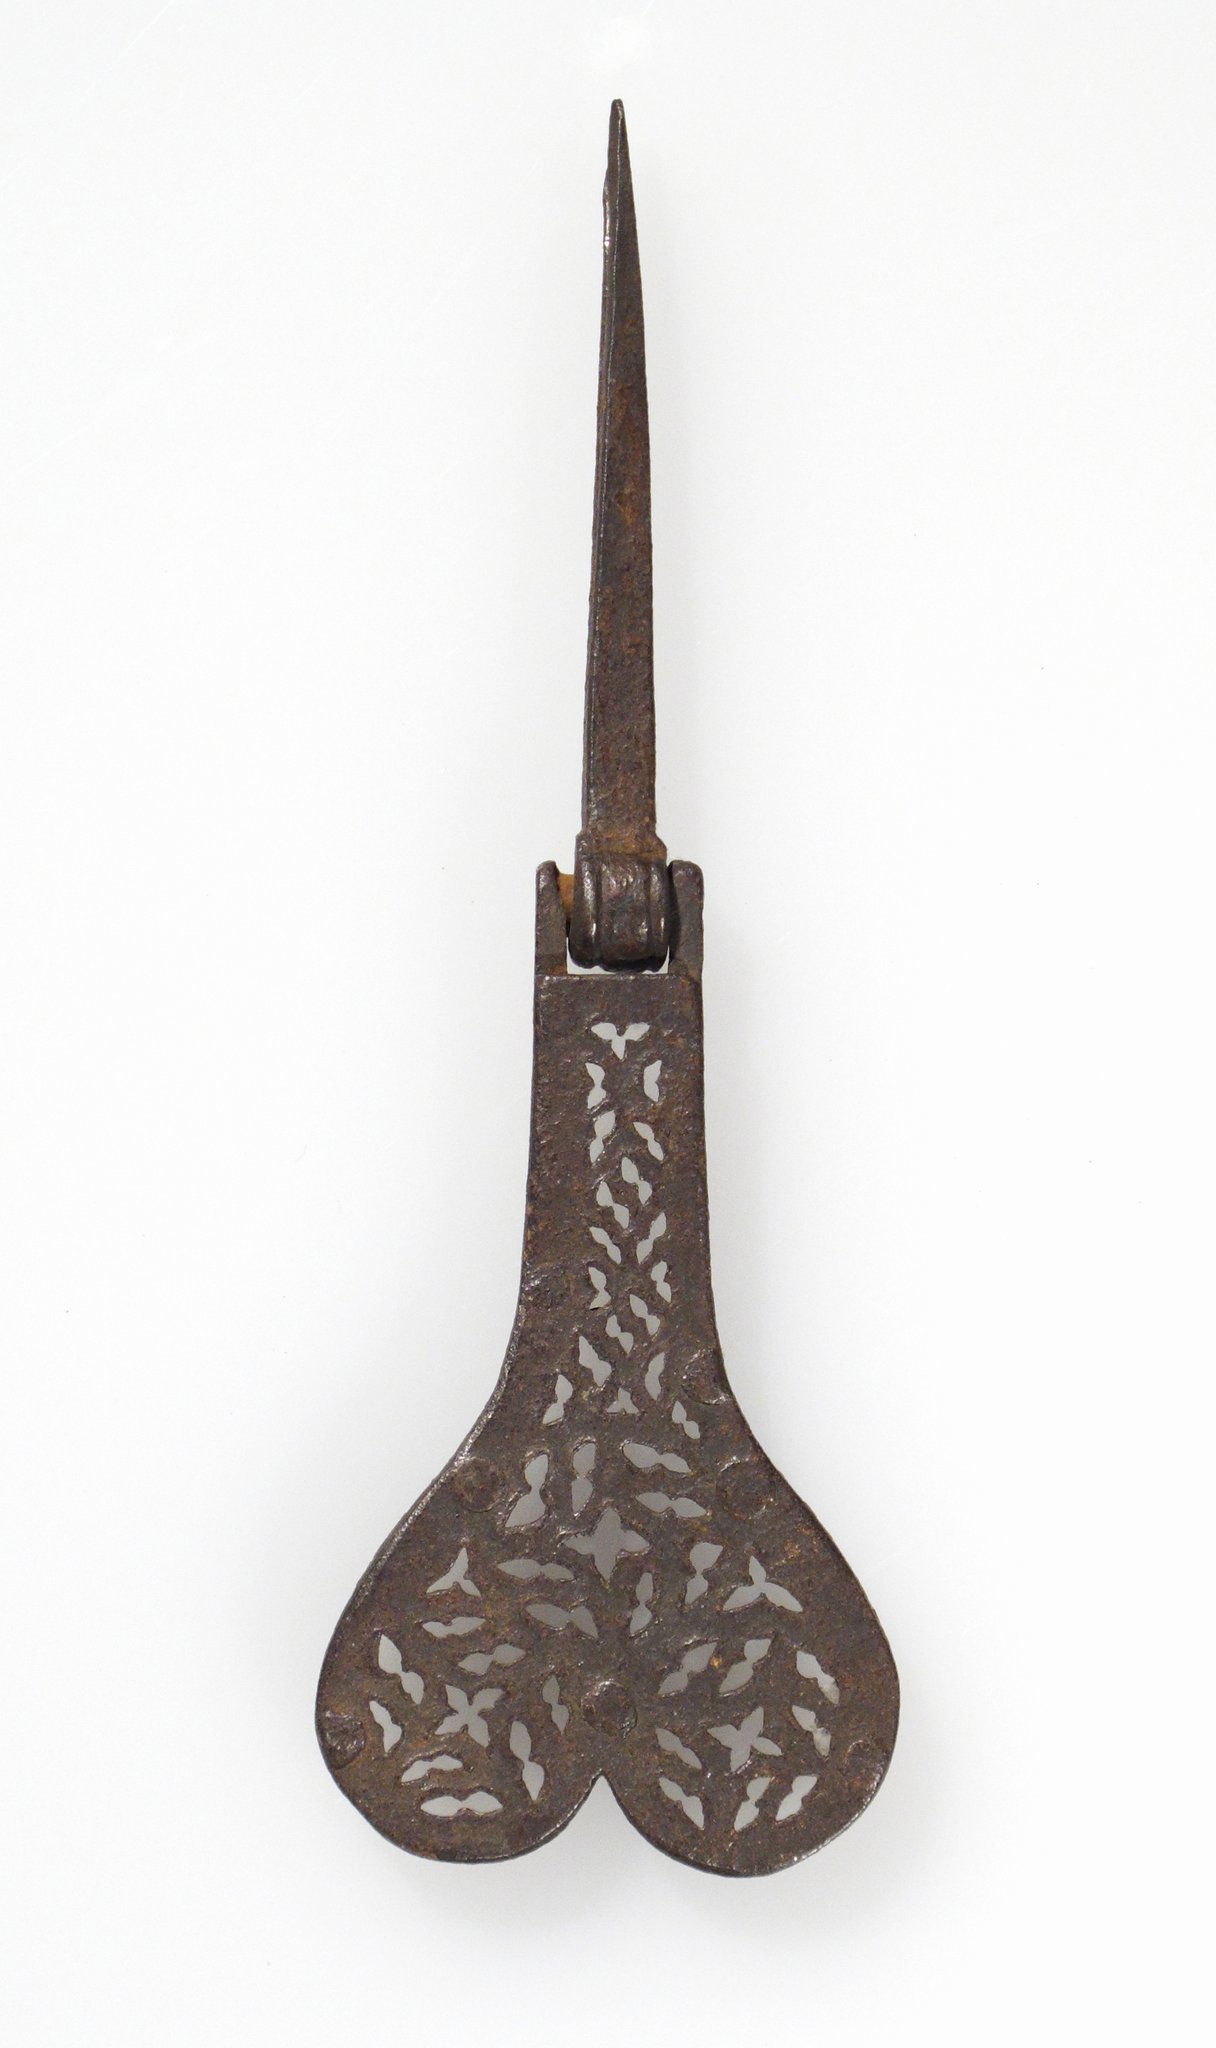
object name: door knocker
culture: european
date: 1401-1600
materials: iron